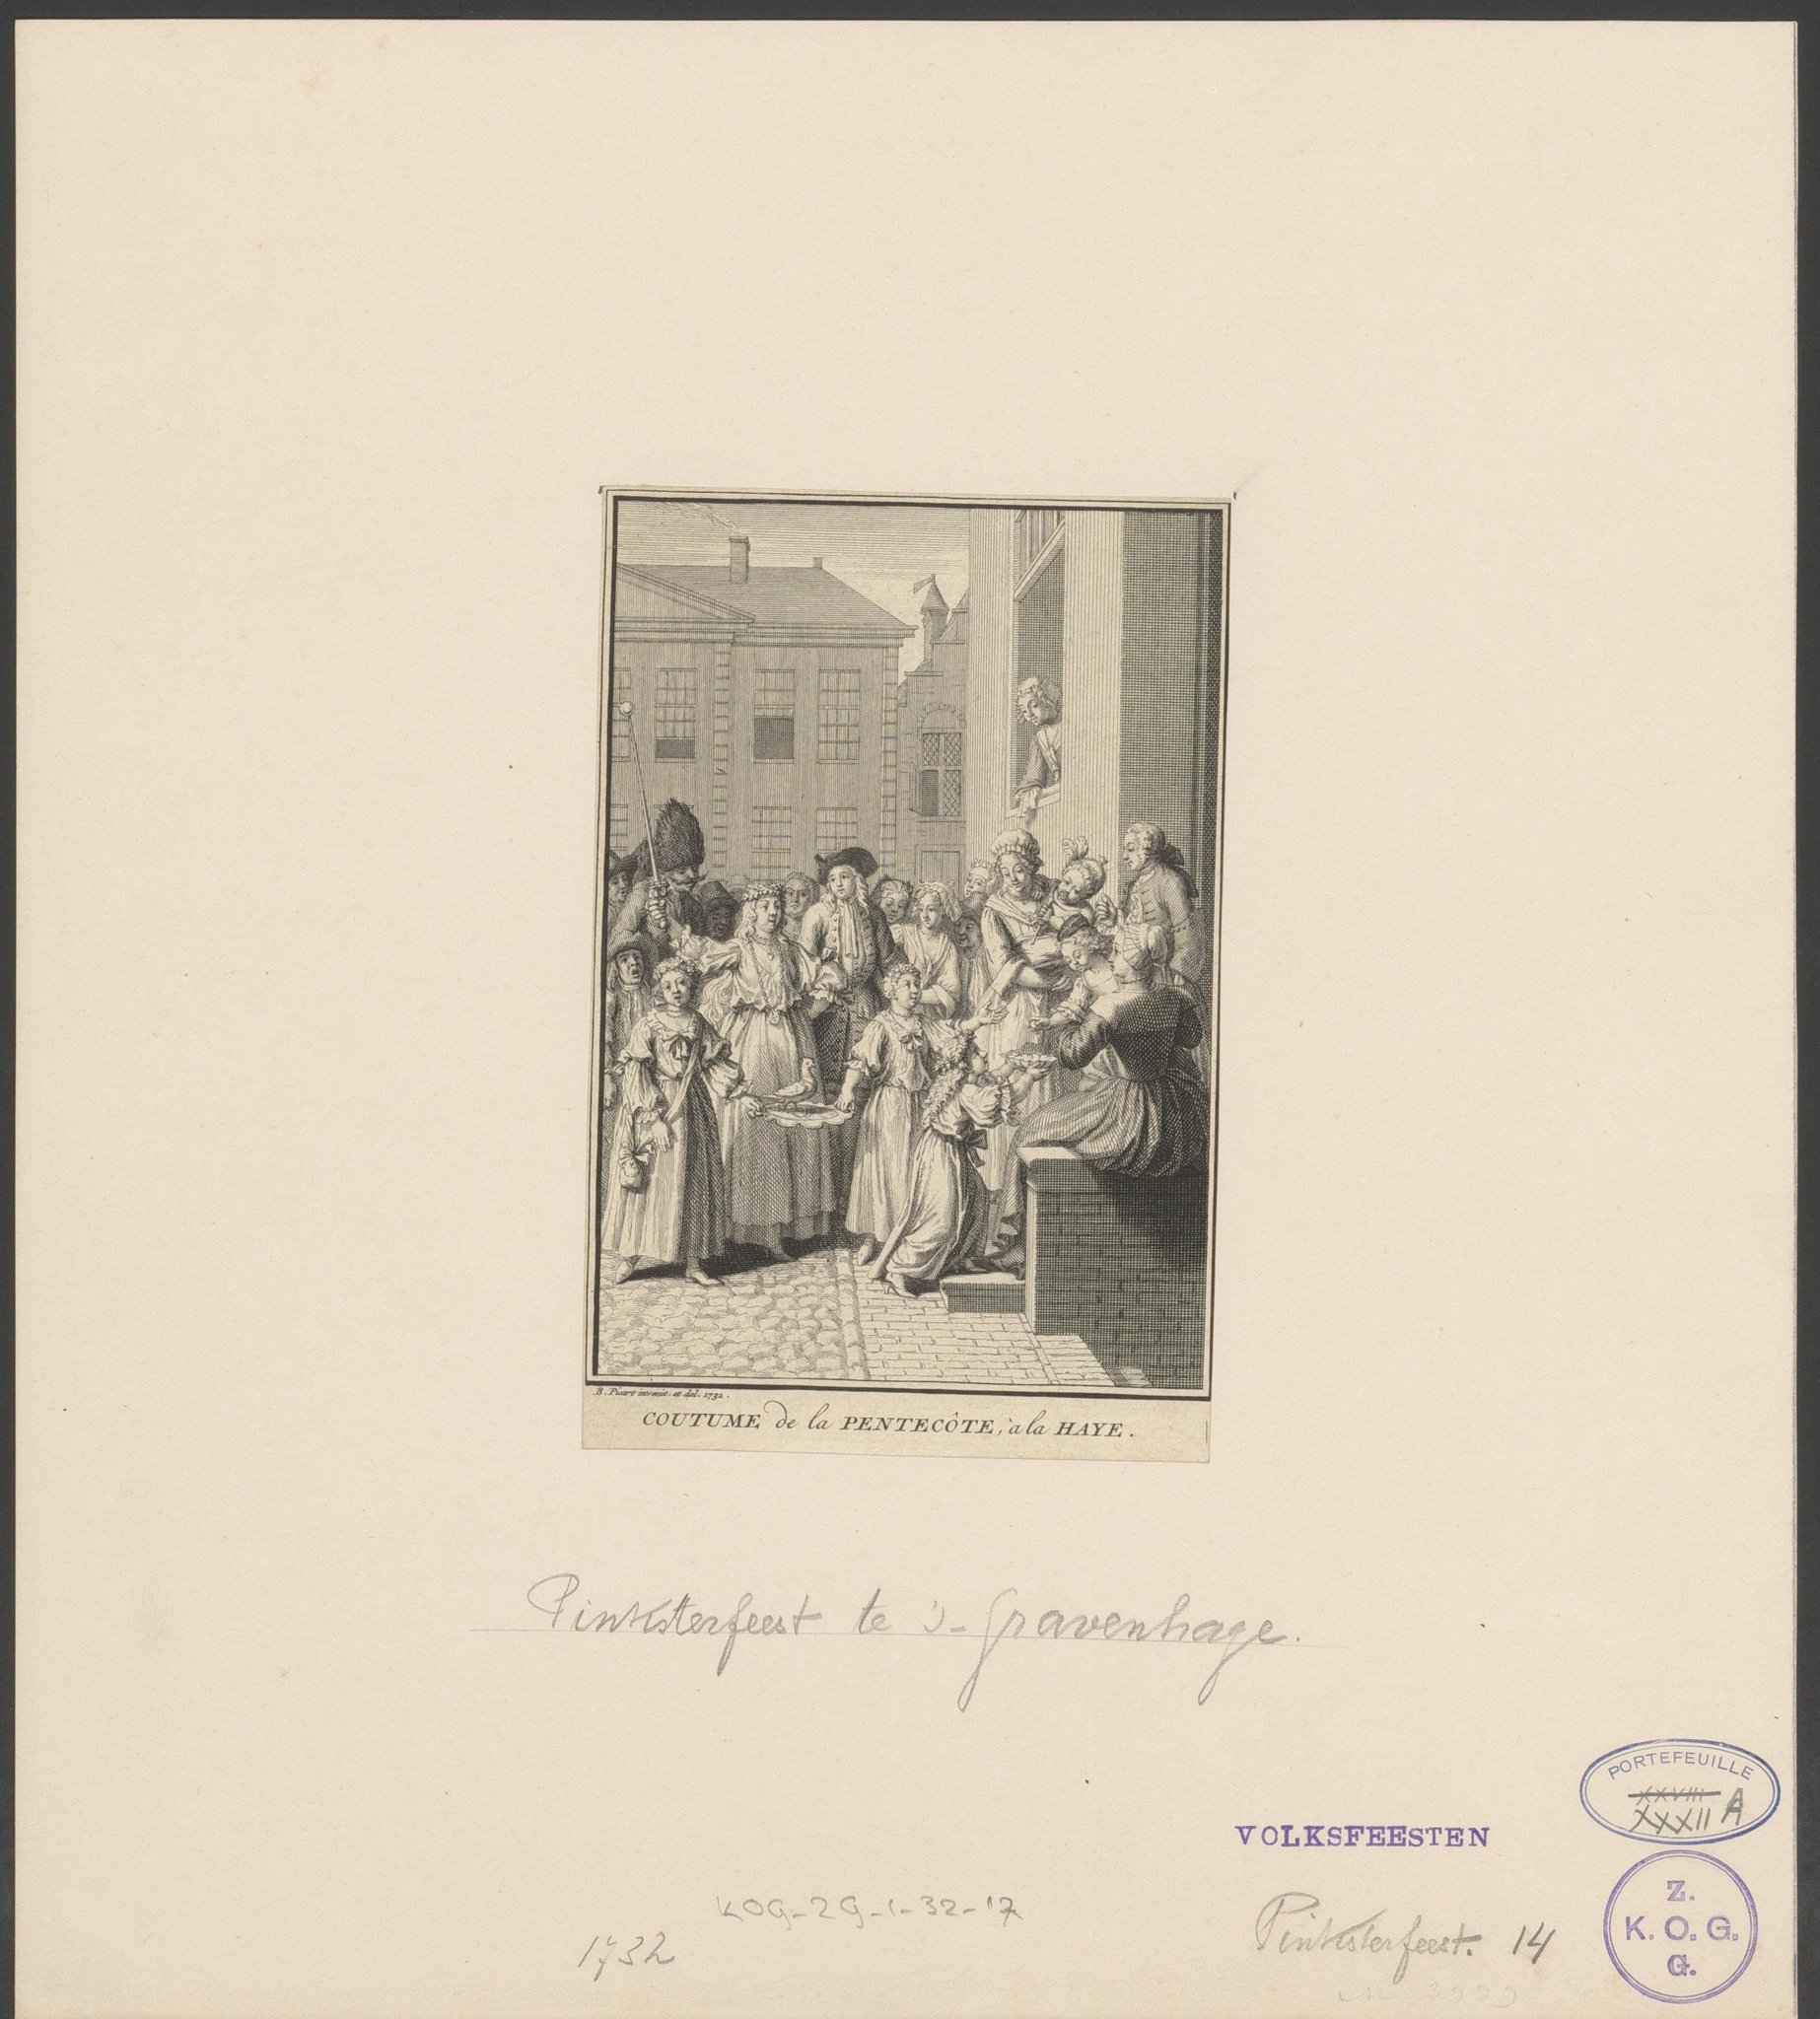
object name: print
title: Coutume de la Pentecôte, à La Haye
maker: bernard picart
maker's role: draughtsman, print maker, publisher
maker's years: 1673-1733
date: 1732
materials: paper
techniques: engraving, etching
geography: amsterdam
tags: pentecost, whitsunday, calendar festivals, non-liturgical celebrations of days belonging to the ecclesiastical calendar, the hague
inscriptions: collector's mark, collector's mark: Lugt 1641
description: Prent ook gebruikt in: Picart, Bernard. Ceremonies et coutumes religieuses de tous les peuples du monde (...). 10 delen. Amsterdam: Jean Frederic Bernard, 1723-1743, deel 3 (1733), na p. 352. En in de Nederlandse vertaling: Picart, Bernard en Abraham Moubach. Naaukeurige beschryving der uitwendige godtsdienst-plichten, kerk-zeden en gewoontens van alle volkeren der waereldt : in een historisch verhaal (...). 6 delen. 's-Gravenhage: Rutgert Christoffel Alberts, 1727-1738, deel 5 (1736), na p. 326.